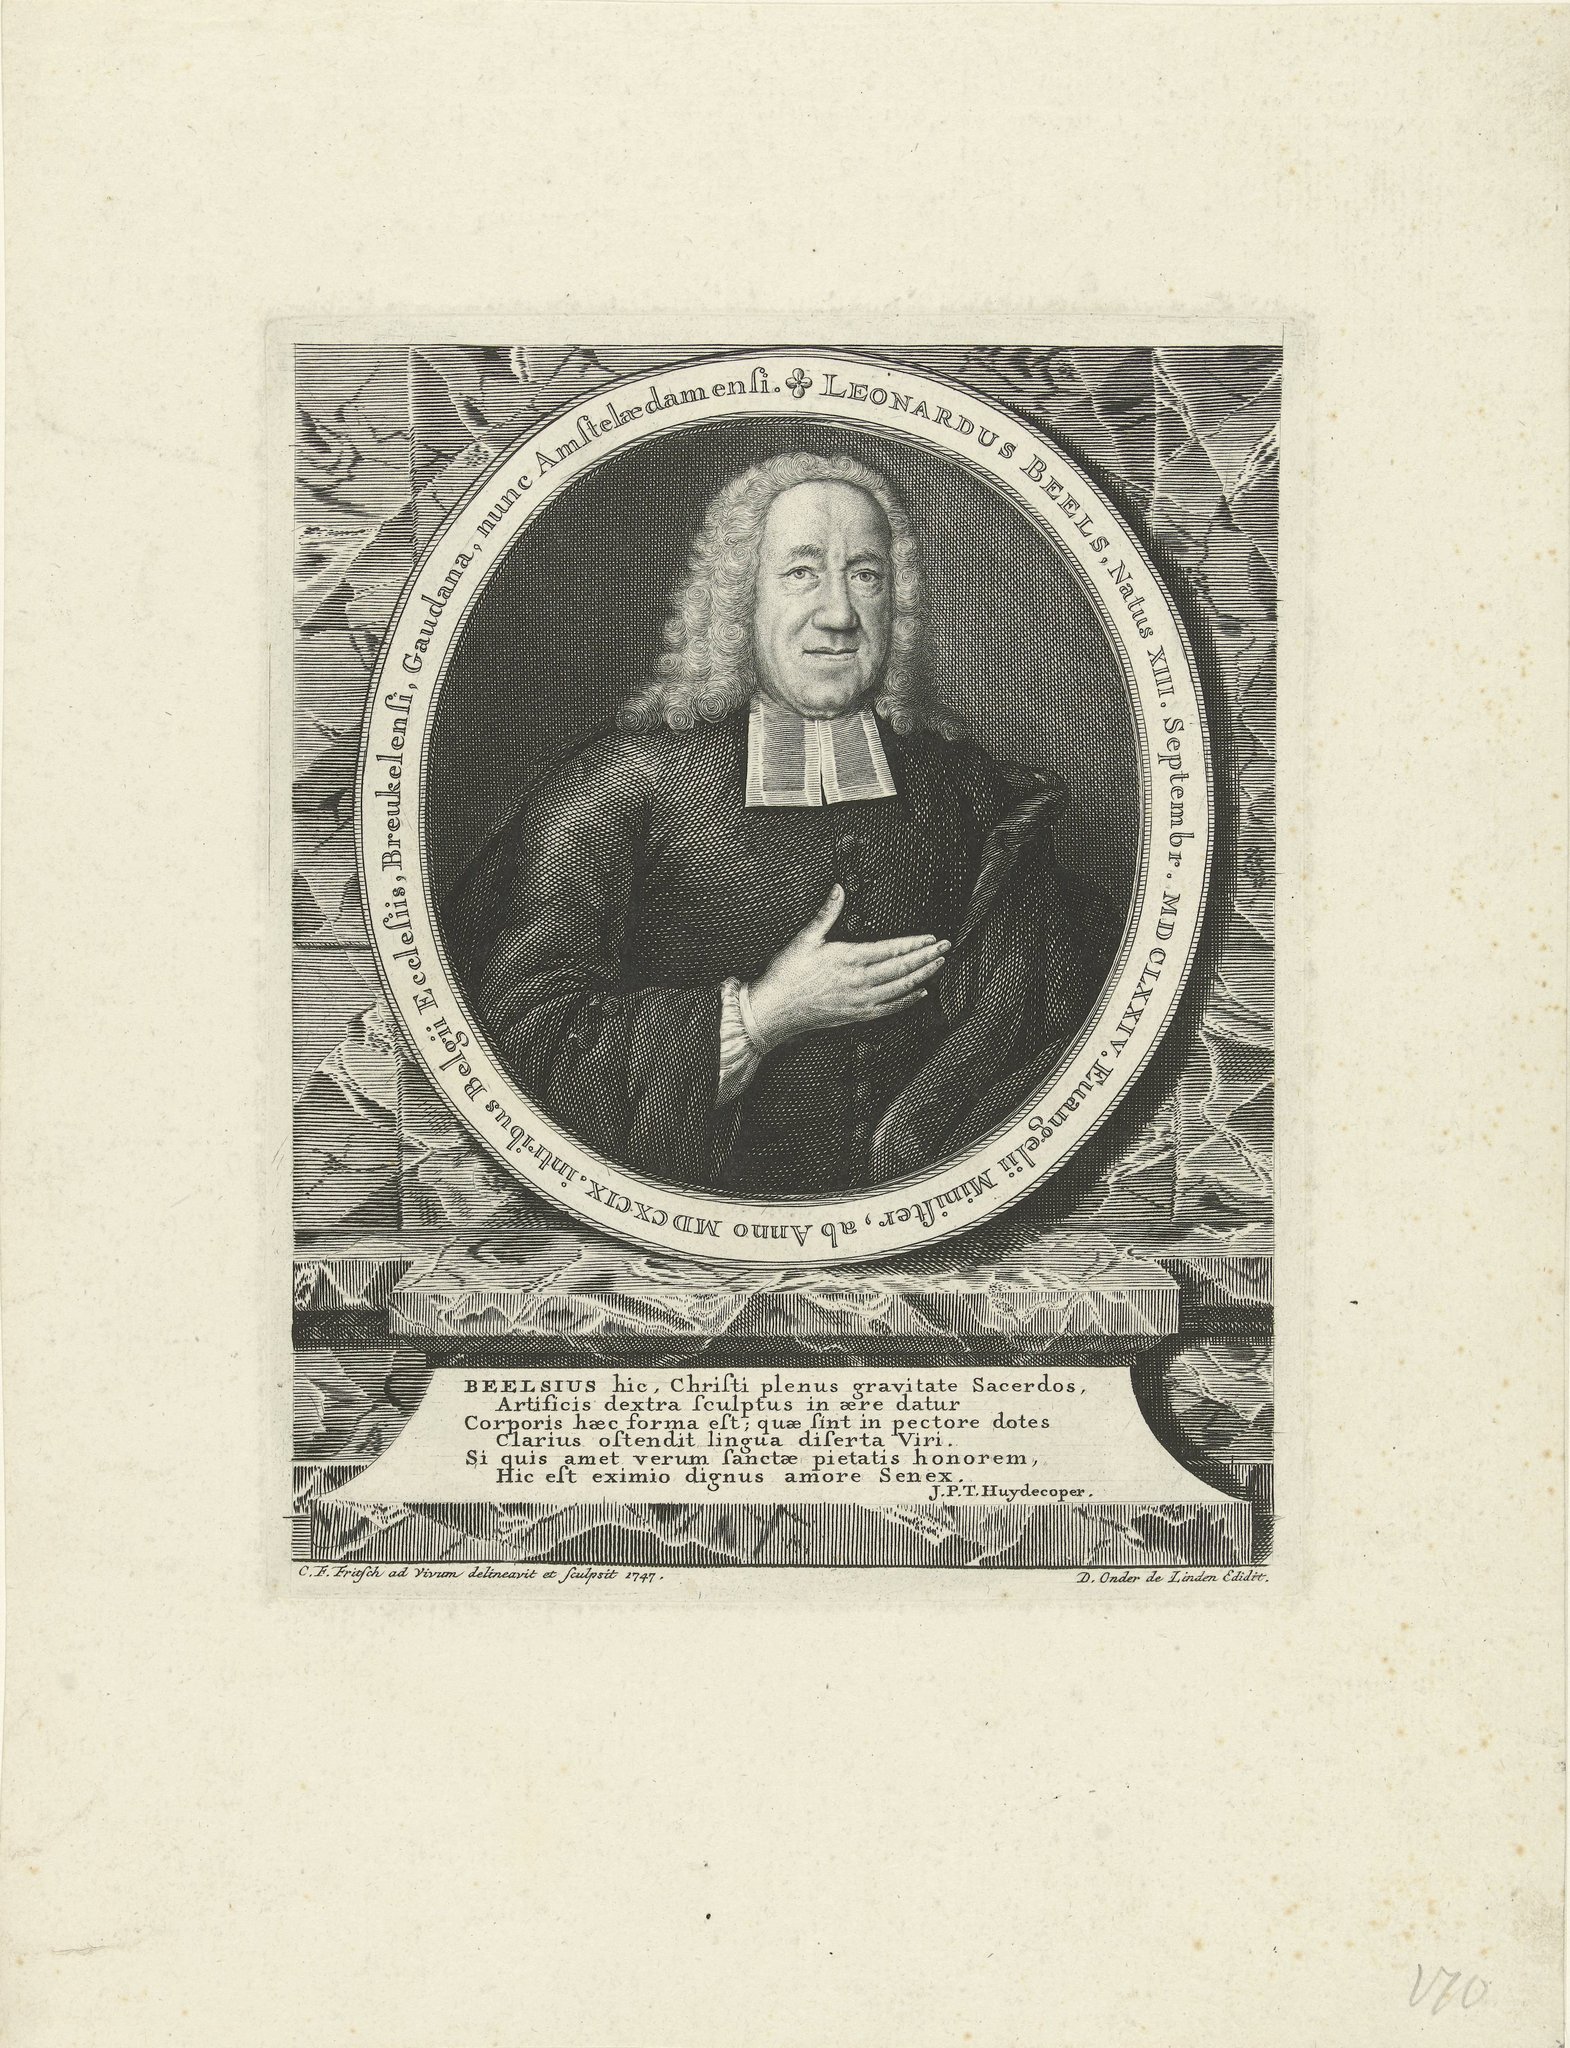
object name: print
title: Portret van Leonard Beels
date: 1747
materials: paper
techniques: engraving, etching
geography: amsterdam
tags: netherlands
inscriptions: collector's mark: Lugt 2228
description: Medaillonportret van predikant Leonard Beels. Ten halven lijve iets naar rechts. In het randschrift rond het portret en op de sokkel onder het medaillon staan Latijnse teksten.